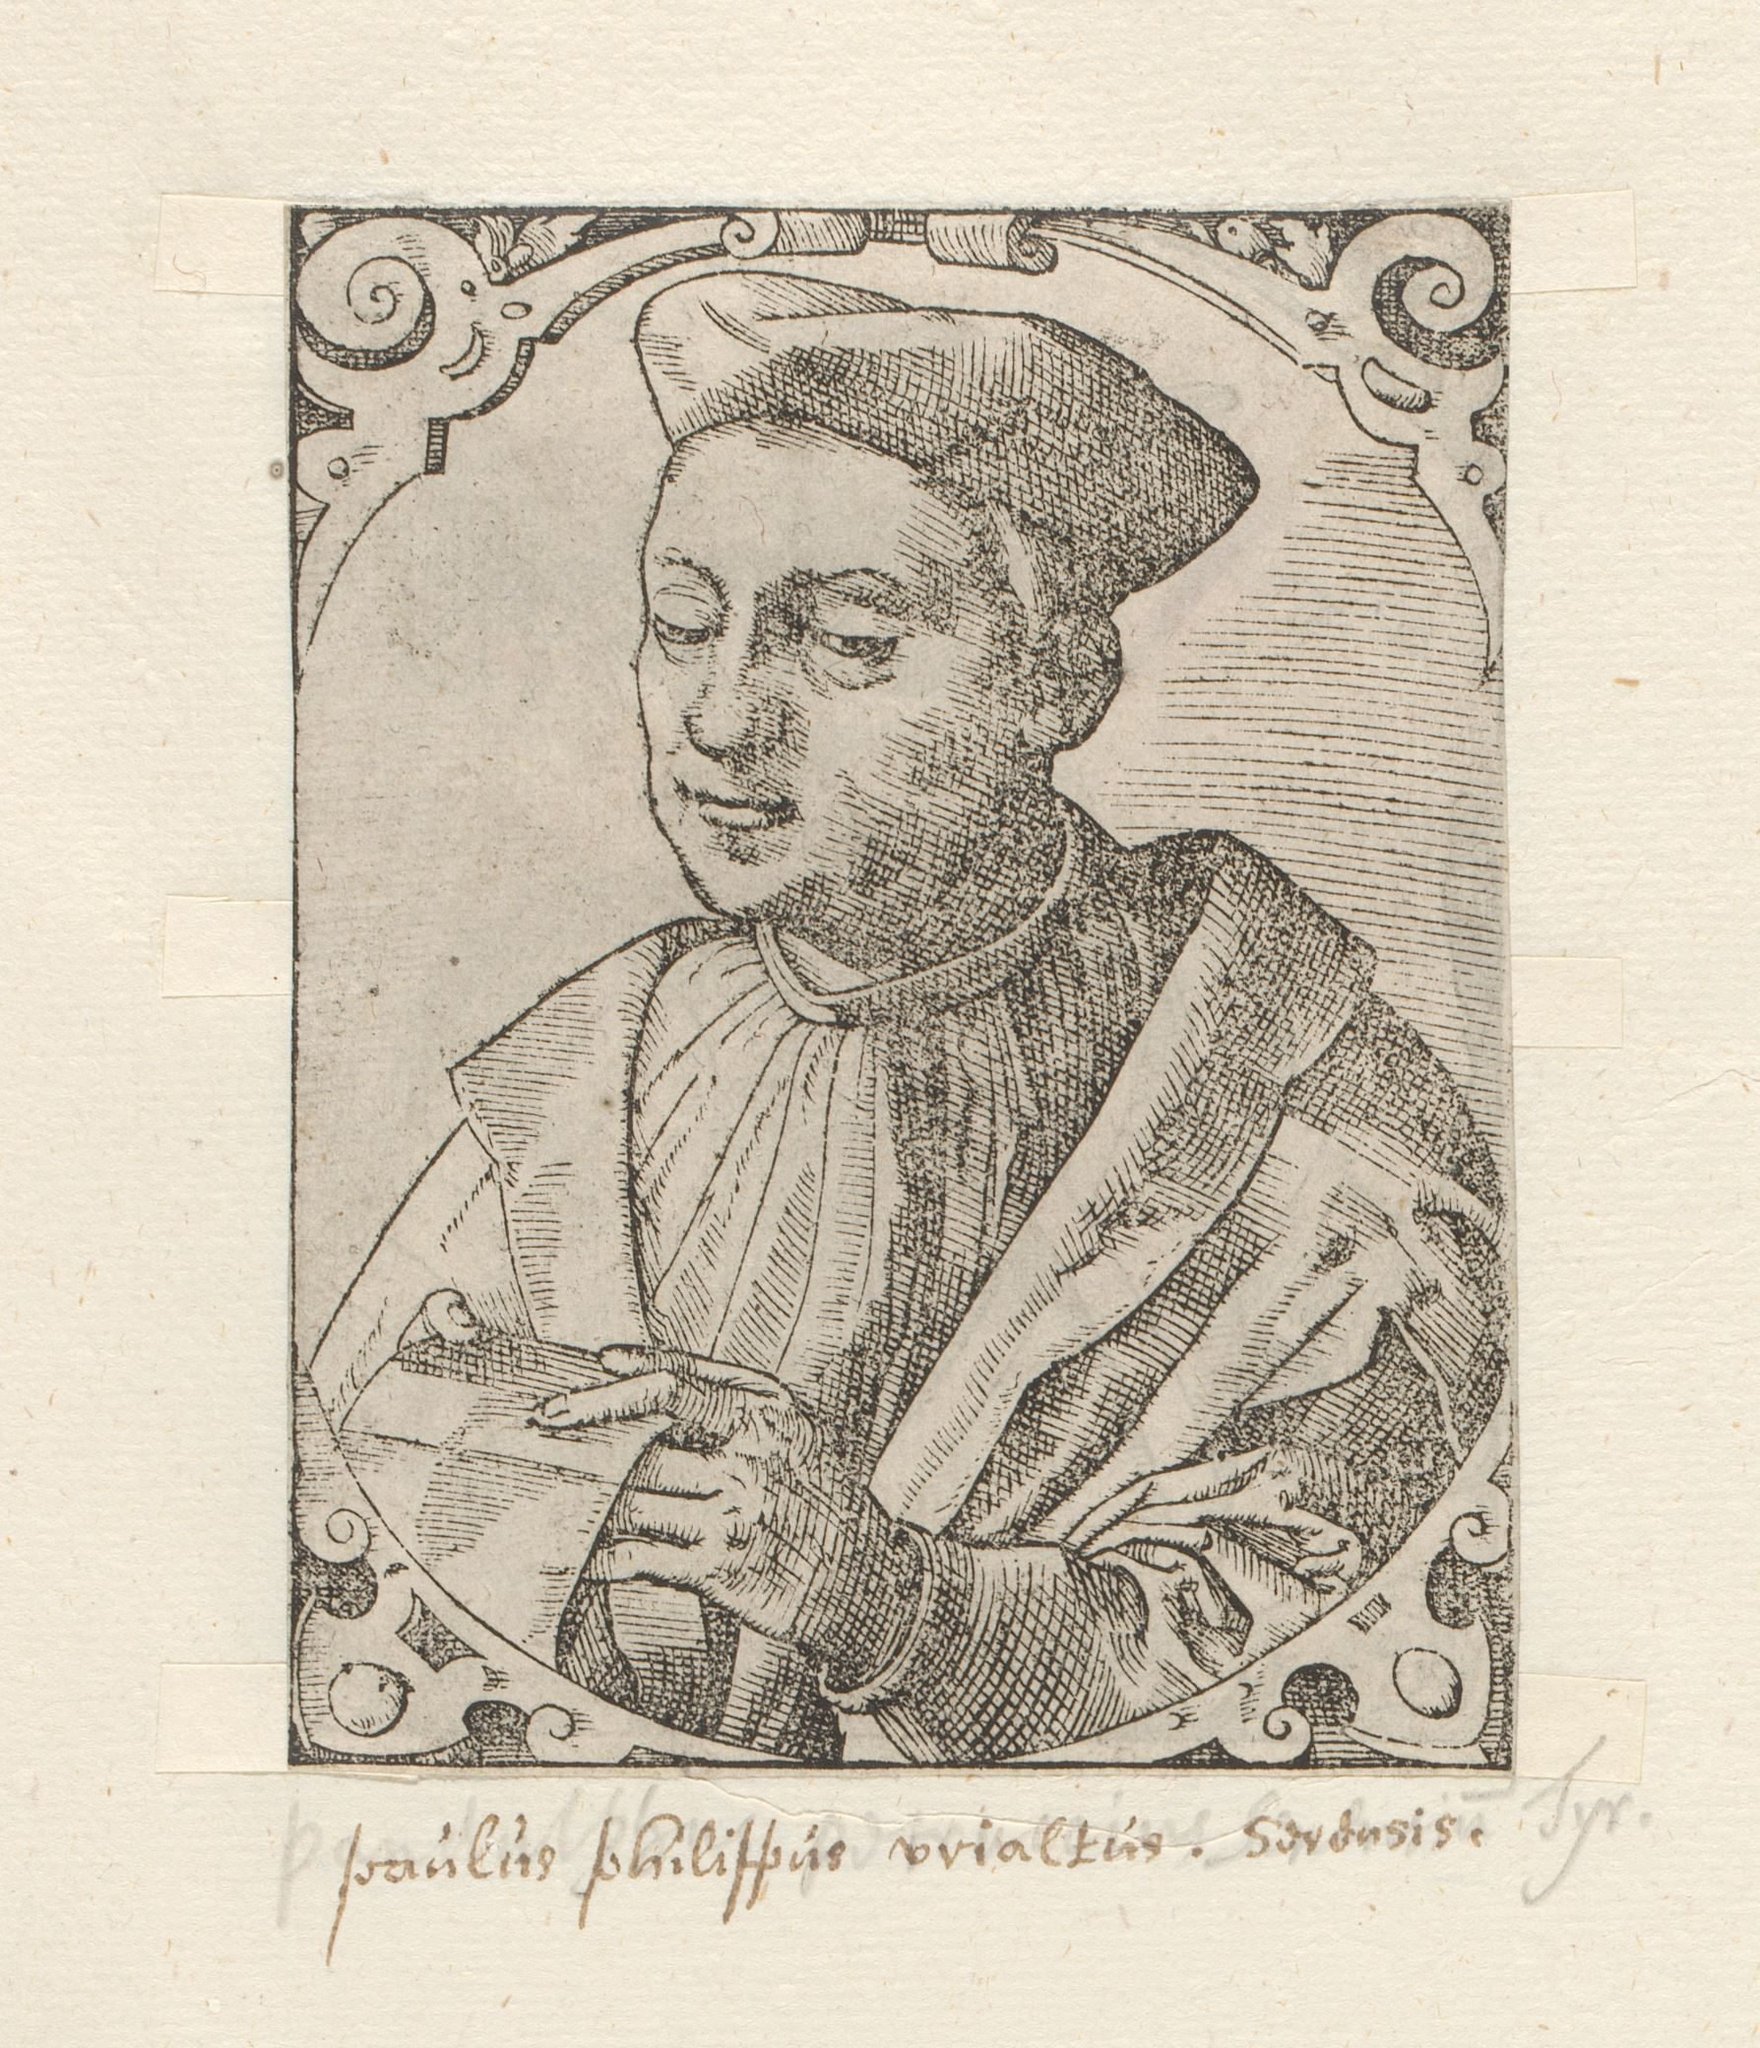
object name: print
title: Portret van Pandolfo Petrucci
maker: Anonymous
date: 1549-1575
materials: paper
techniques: woodcut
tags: historical persons, politician, e.g. party leader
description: Prent gebruikt in: Giovio, Paolo. Elogia Virorum bellica virtute illustrium (...). Bazel: Peter Perna, 1575.